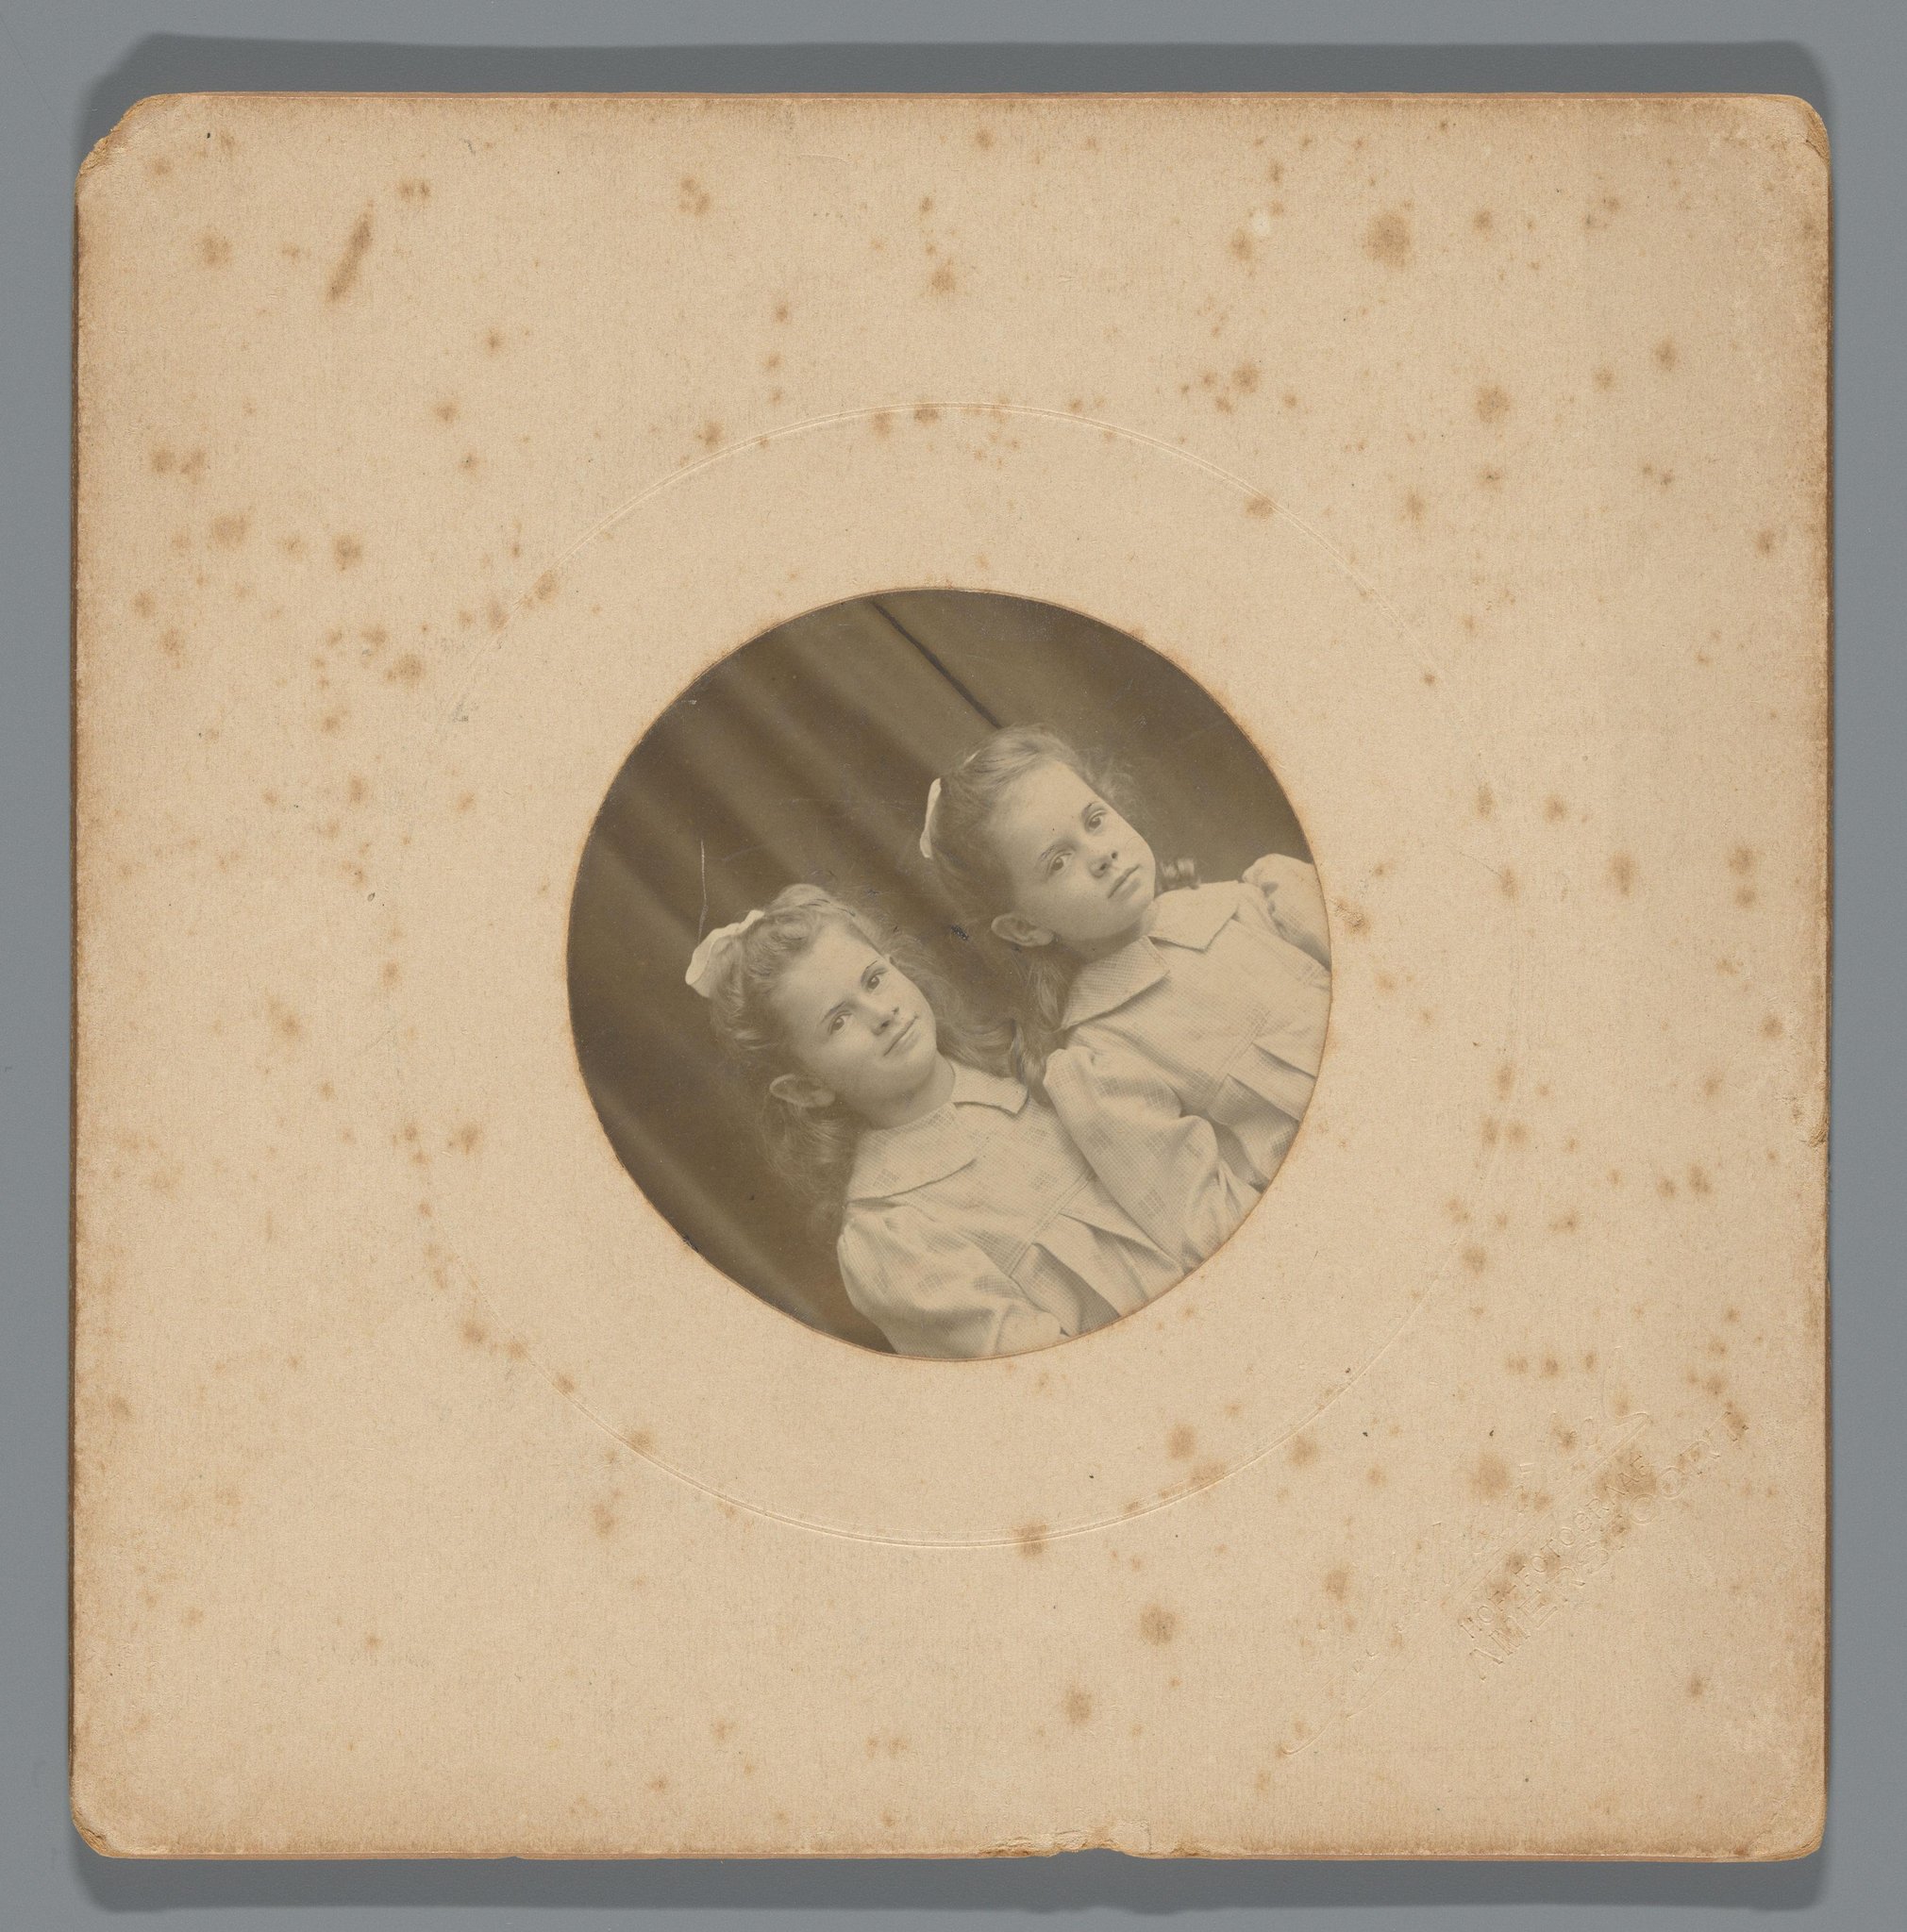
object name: photograph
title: Portret van twee onbekende meisjes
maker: j.h. hentzel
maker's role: fotograaf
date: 1900-1920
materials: paper, cardboard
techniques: matte daylight collodion silver print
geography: amersfoort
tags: girl (child between toddler and youth), anonymous historical persons portrayed in a double portrait